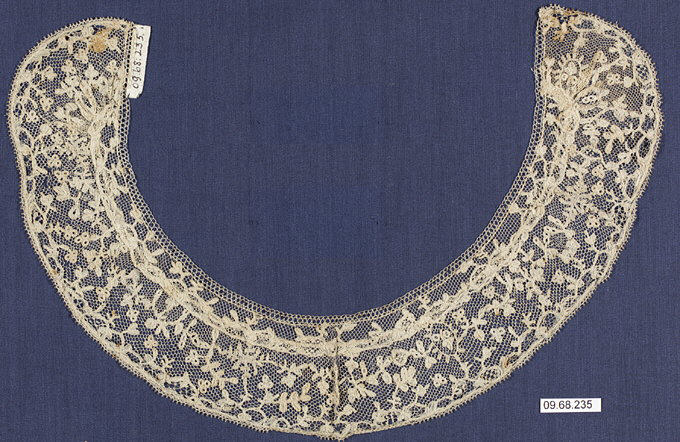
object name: collar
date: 1801-1900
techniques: lace